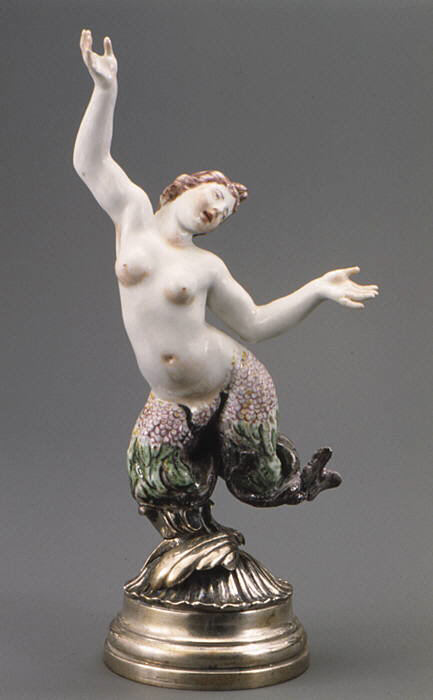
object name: figure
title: Merman (one of six)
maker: doccia porcelain manufactory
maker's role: manufactory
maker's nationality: italian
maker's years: 1737-1896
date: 1750-1755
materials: hard paste porcelain, silver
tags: mermaids